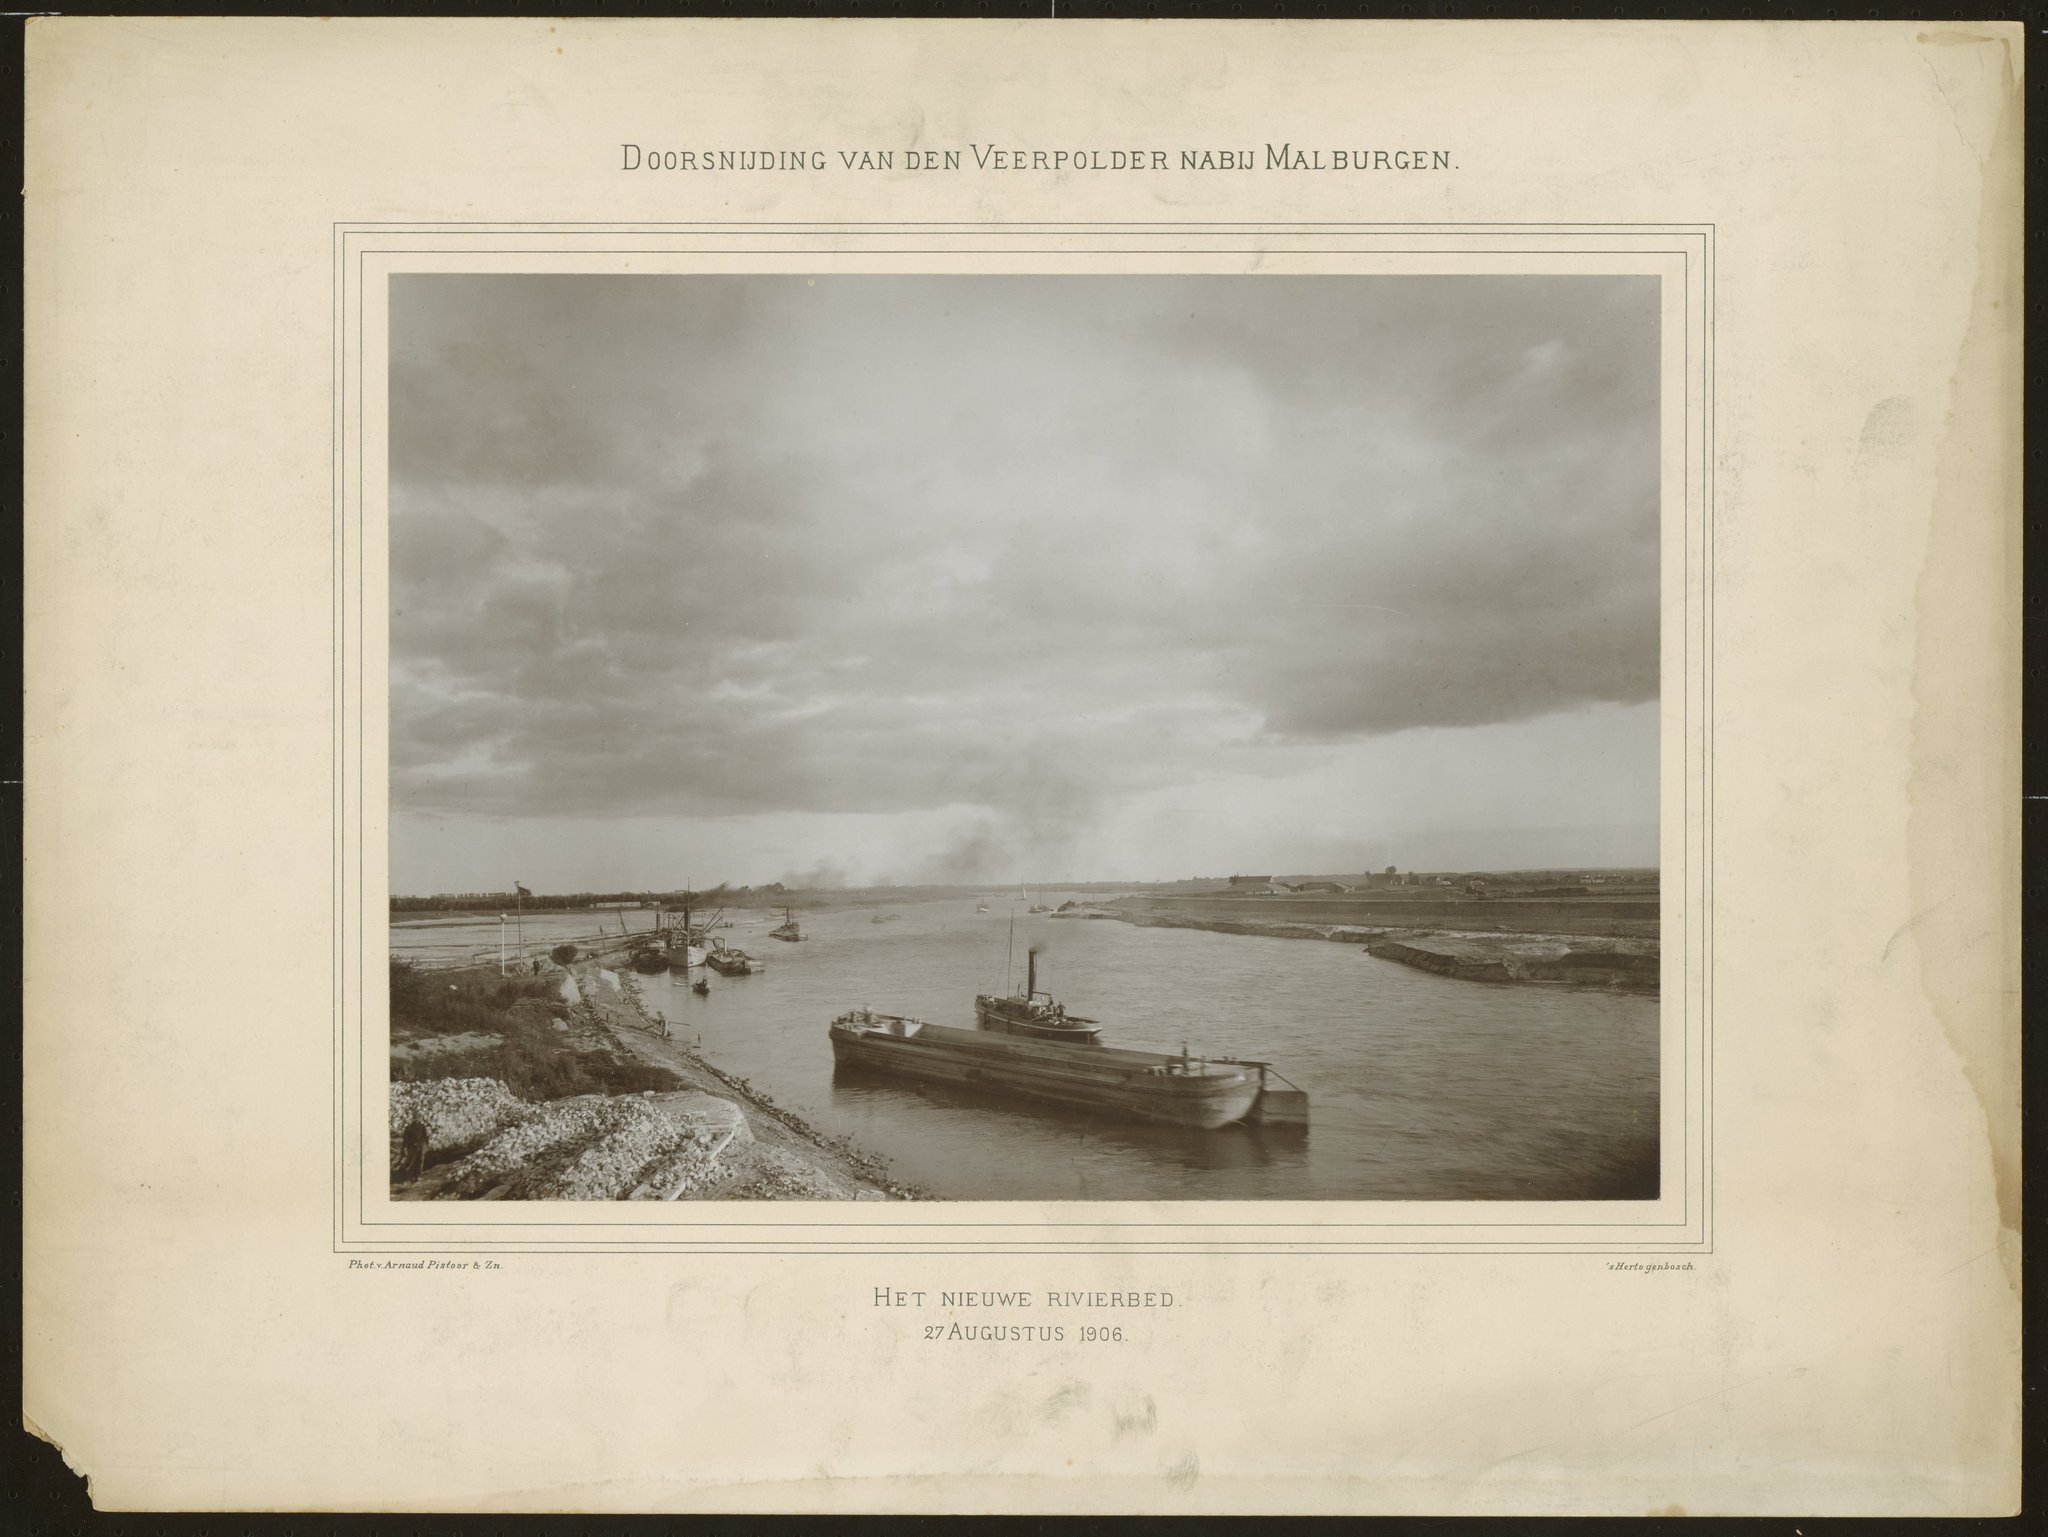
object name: photograph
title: Doorsnijding van den Veerpolder nabij Malburgen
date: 1906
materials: cardboard, paper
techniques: photography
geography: den bosch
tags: malburgen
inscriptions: date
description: Foto op karton. Opschrift: 'Het nieuwe rivierbed, 27 Augustus 1906'. Gedateeerd en gesigneerd.